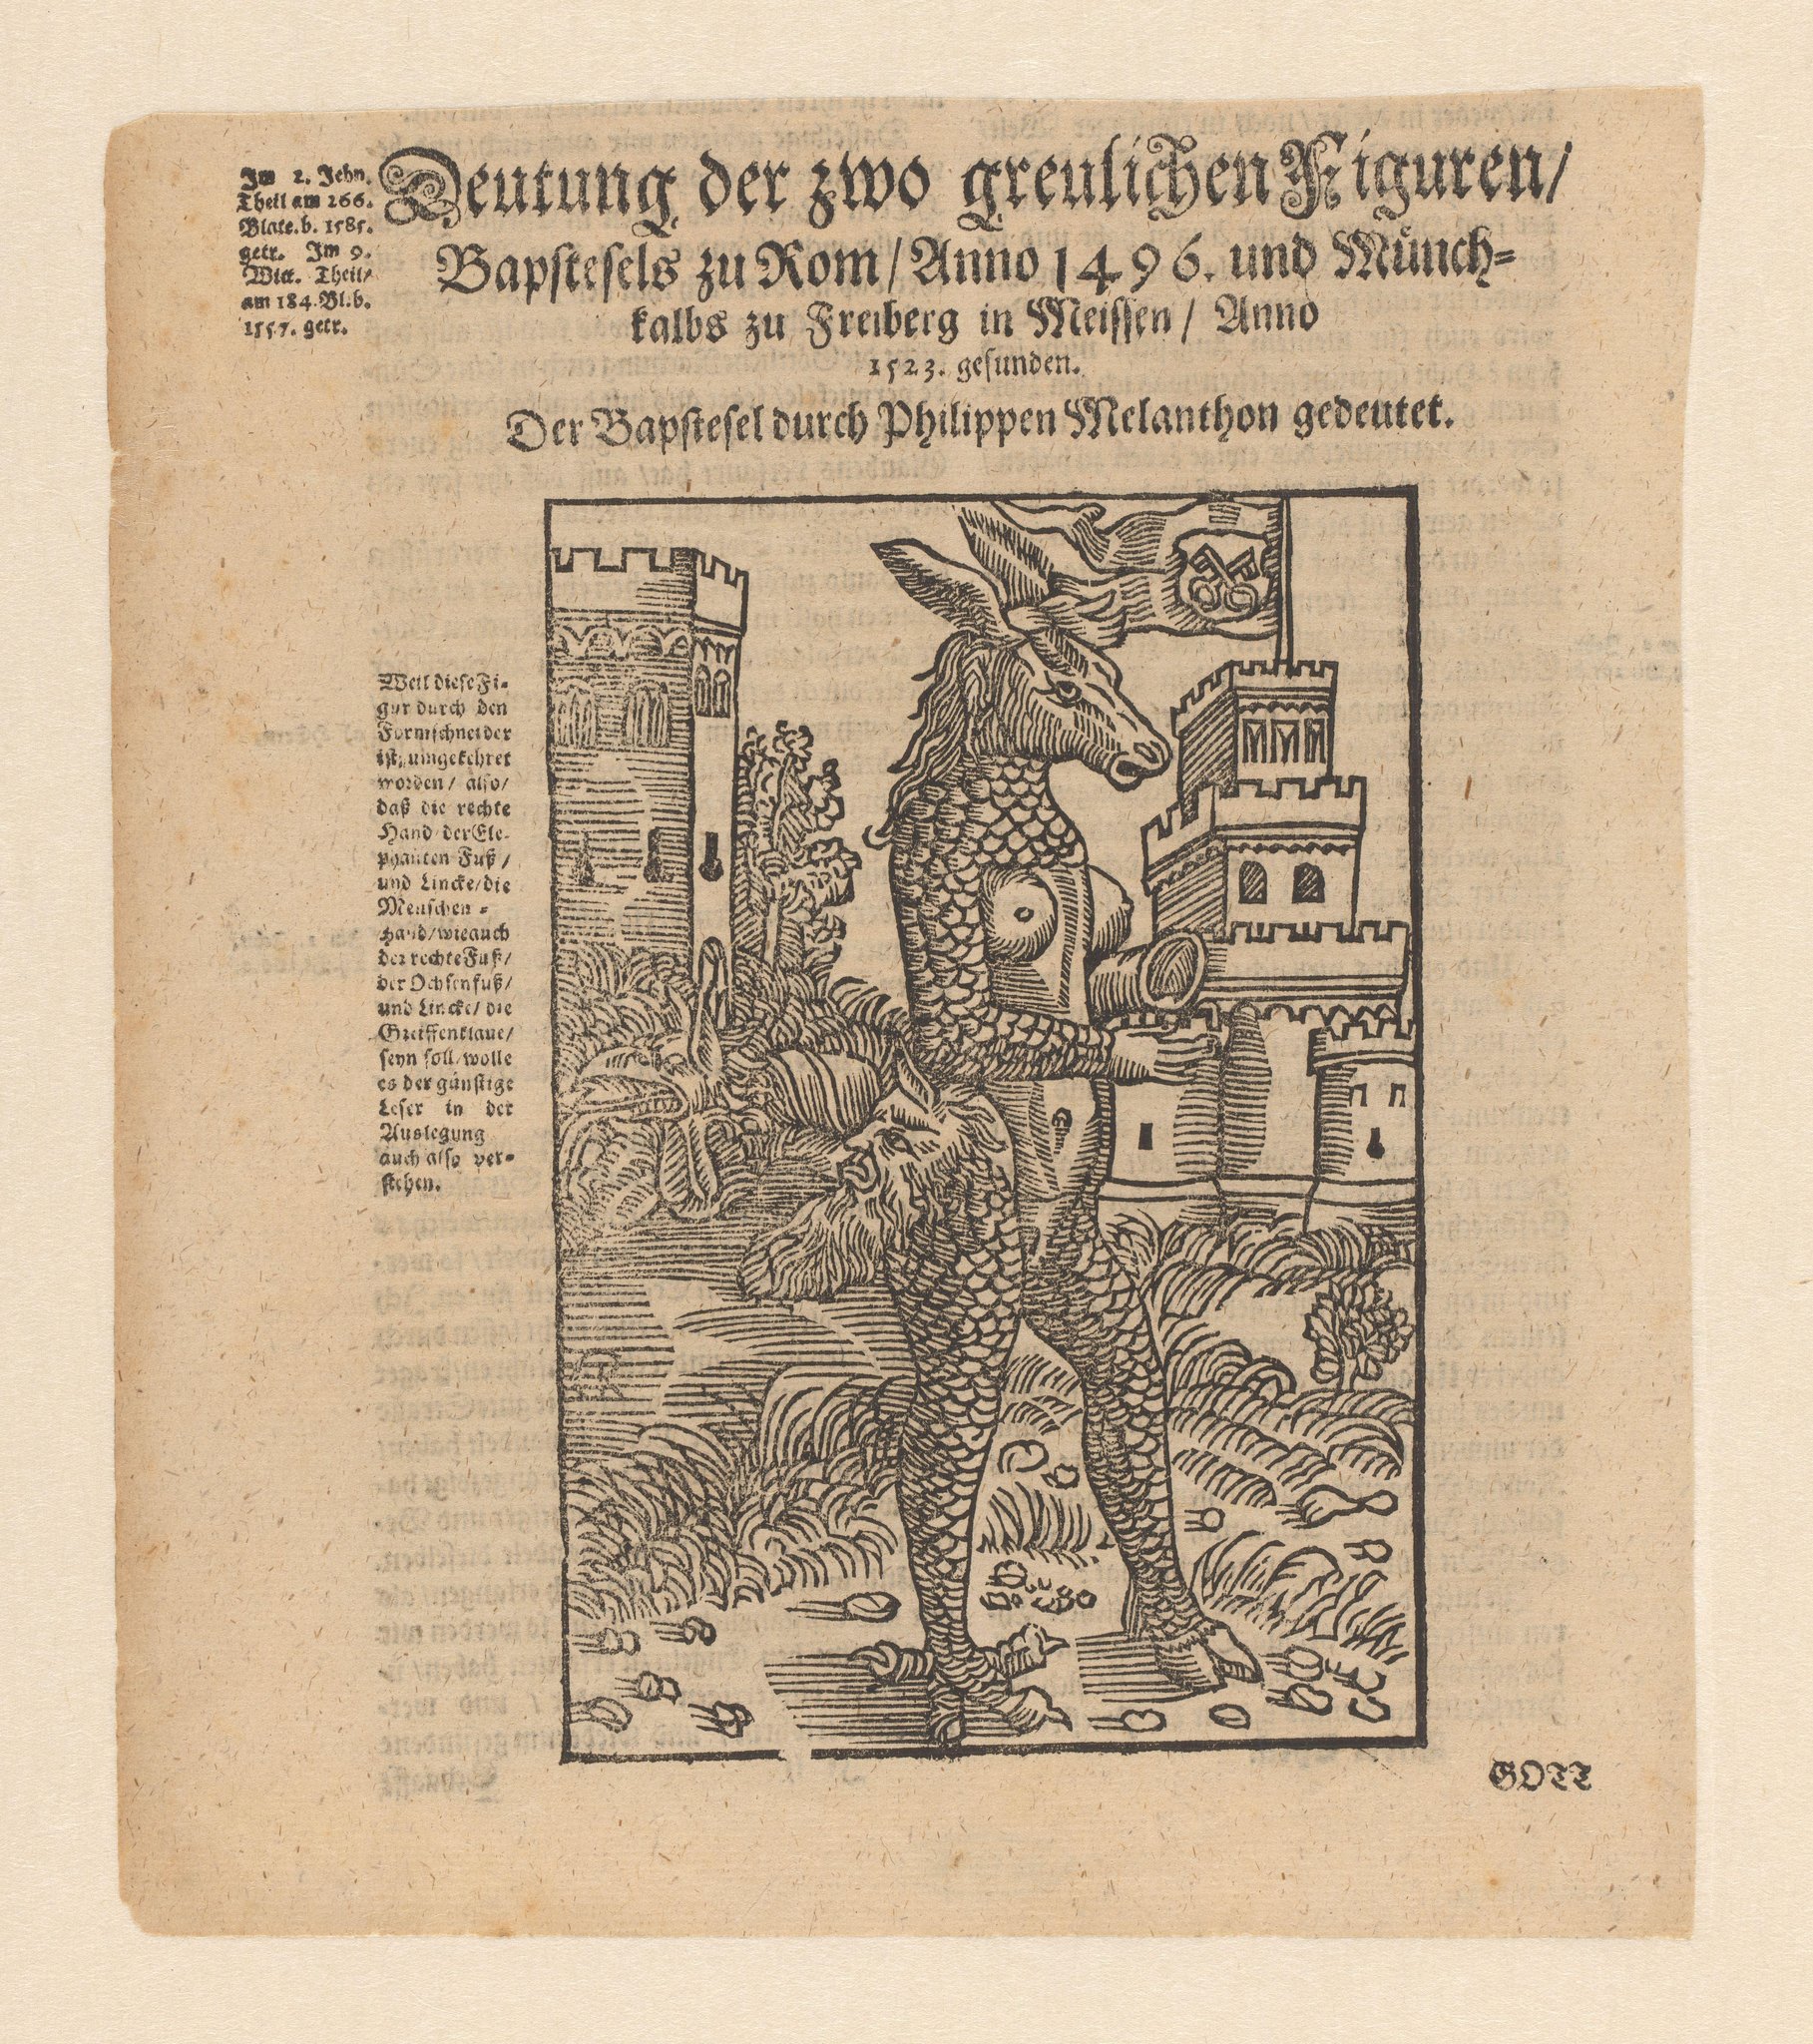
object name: cartoon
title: Deutung der zwo greulichen Figuren / Bapstesels zu Rom / Anno 1496. und Münchkalbs zu Freiburg in Meissen / Anno 1523. gefunden. Der Bapstesel; durch Philippen Melanthon gedeutet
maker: monogrammist gk (prentmaker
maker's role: print maker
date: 1661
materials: paper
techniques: letterpress printing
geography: europe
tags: priest, martin luther, ass, donkey, monsters ~ hoofed animals, monsters with parts, limbs, organs, etc. of abnormal shape, (aspects of) christian religion or the church (as institution) ridiculed, criticized, or caricaturized, rome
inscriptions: collector's mark: Lugt 2228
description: Duitse spotprent met een reformatorische interpretatie van de zgn. pauselijke esel (Papstesel of Bapstesel), een mismaakte ezelin met dierlijke, menselijke en monsterlijke onderdelen, in 1496 dood in de Tiber te Rome gevonden. Spiegelbeeldige kopie naar de oorspronkelijke houtsnede van Lucas Cranach in het satirische antikatholieke pamflet 'Der Bapstesel zu Rom' van Martin Luther en Philipp Melanchthon uit 1523.